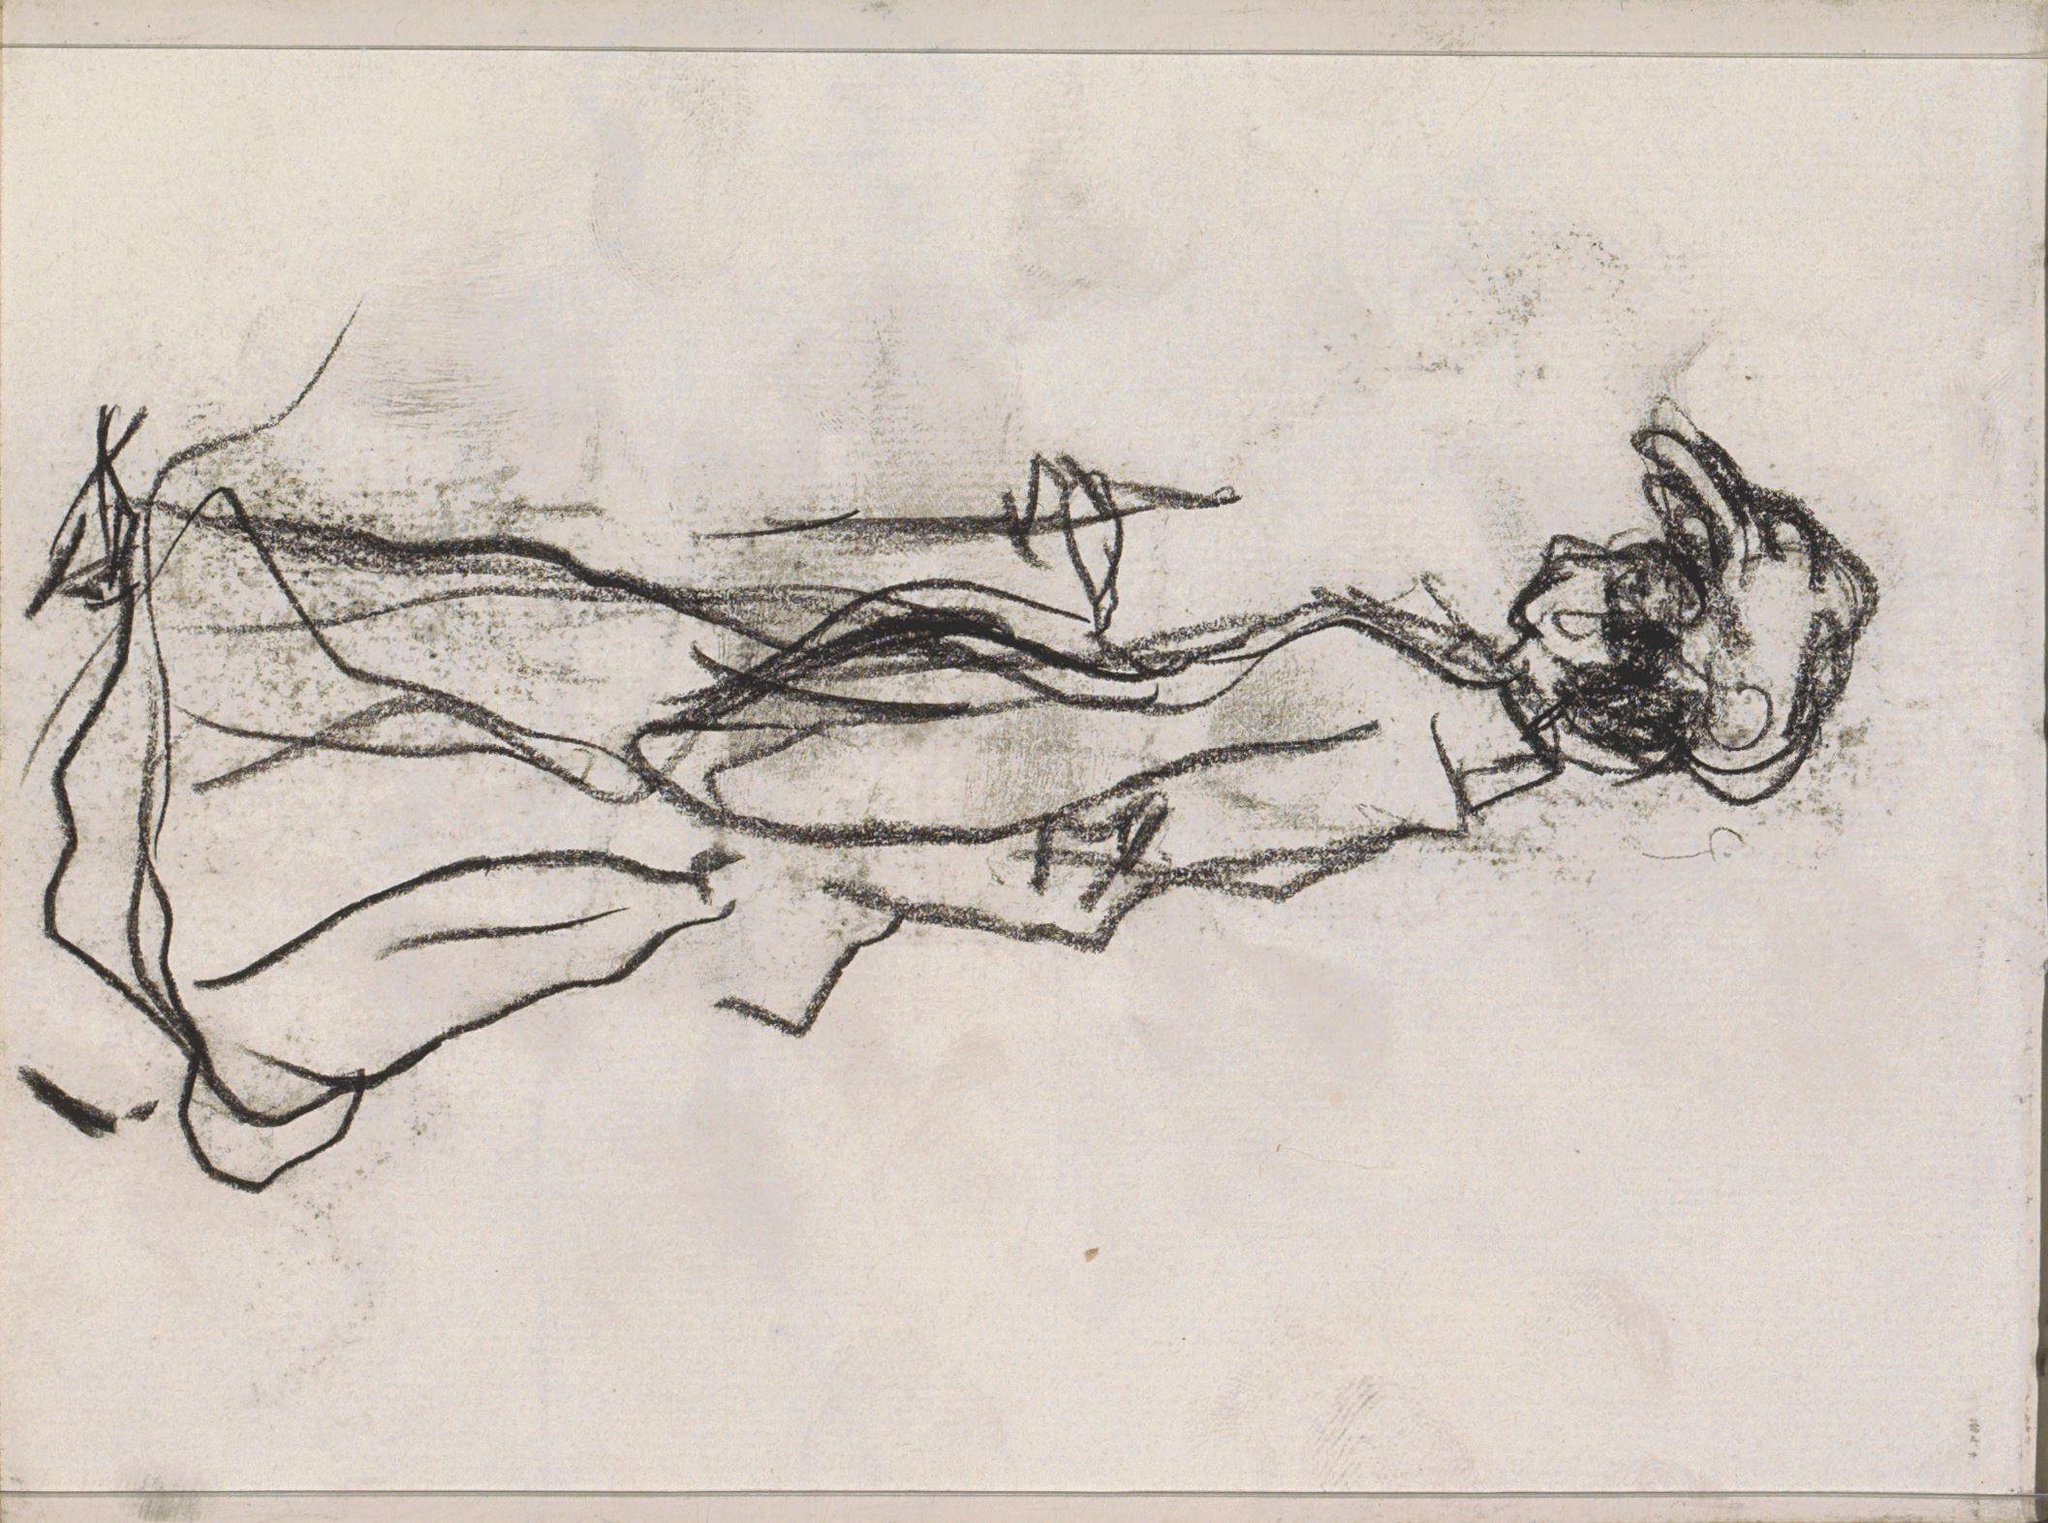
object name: sketchbook leaf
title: Staande vrouw met hoed, in profiel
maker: isaac israels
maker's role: draughtsman, painter, print maker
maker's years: 1865-1934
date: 1875-1934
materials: chalk, paper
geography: the hague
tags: head-gear: hat (+ women's clothes), adult woman (+ standing)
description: Pagina 16 uit schetsboek XLI met 38 pagina's.